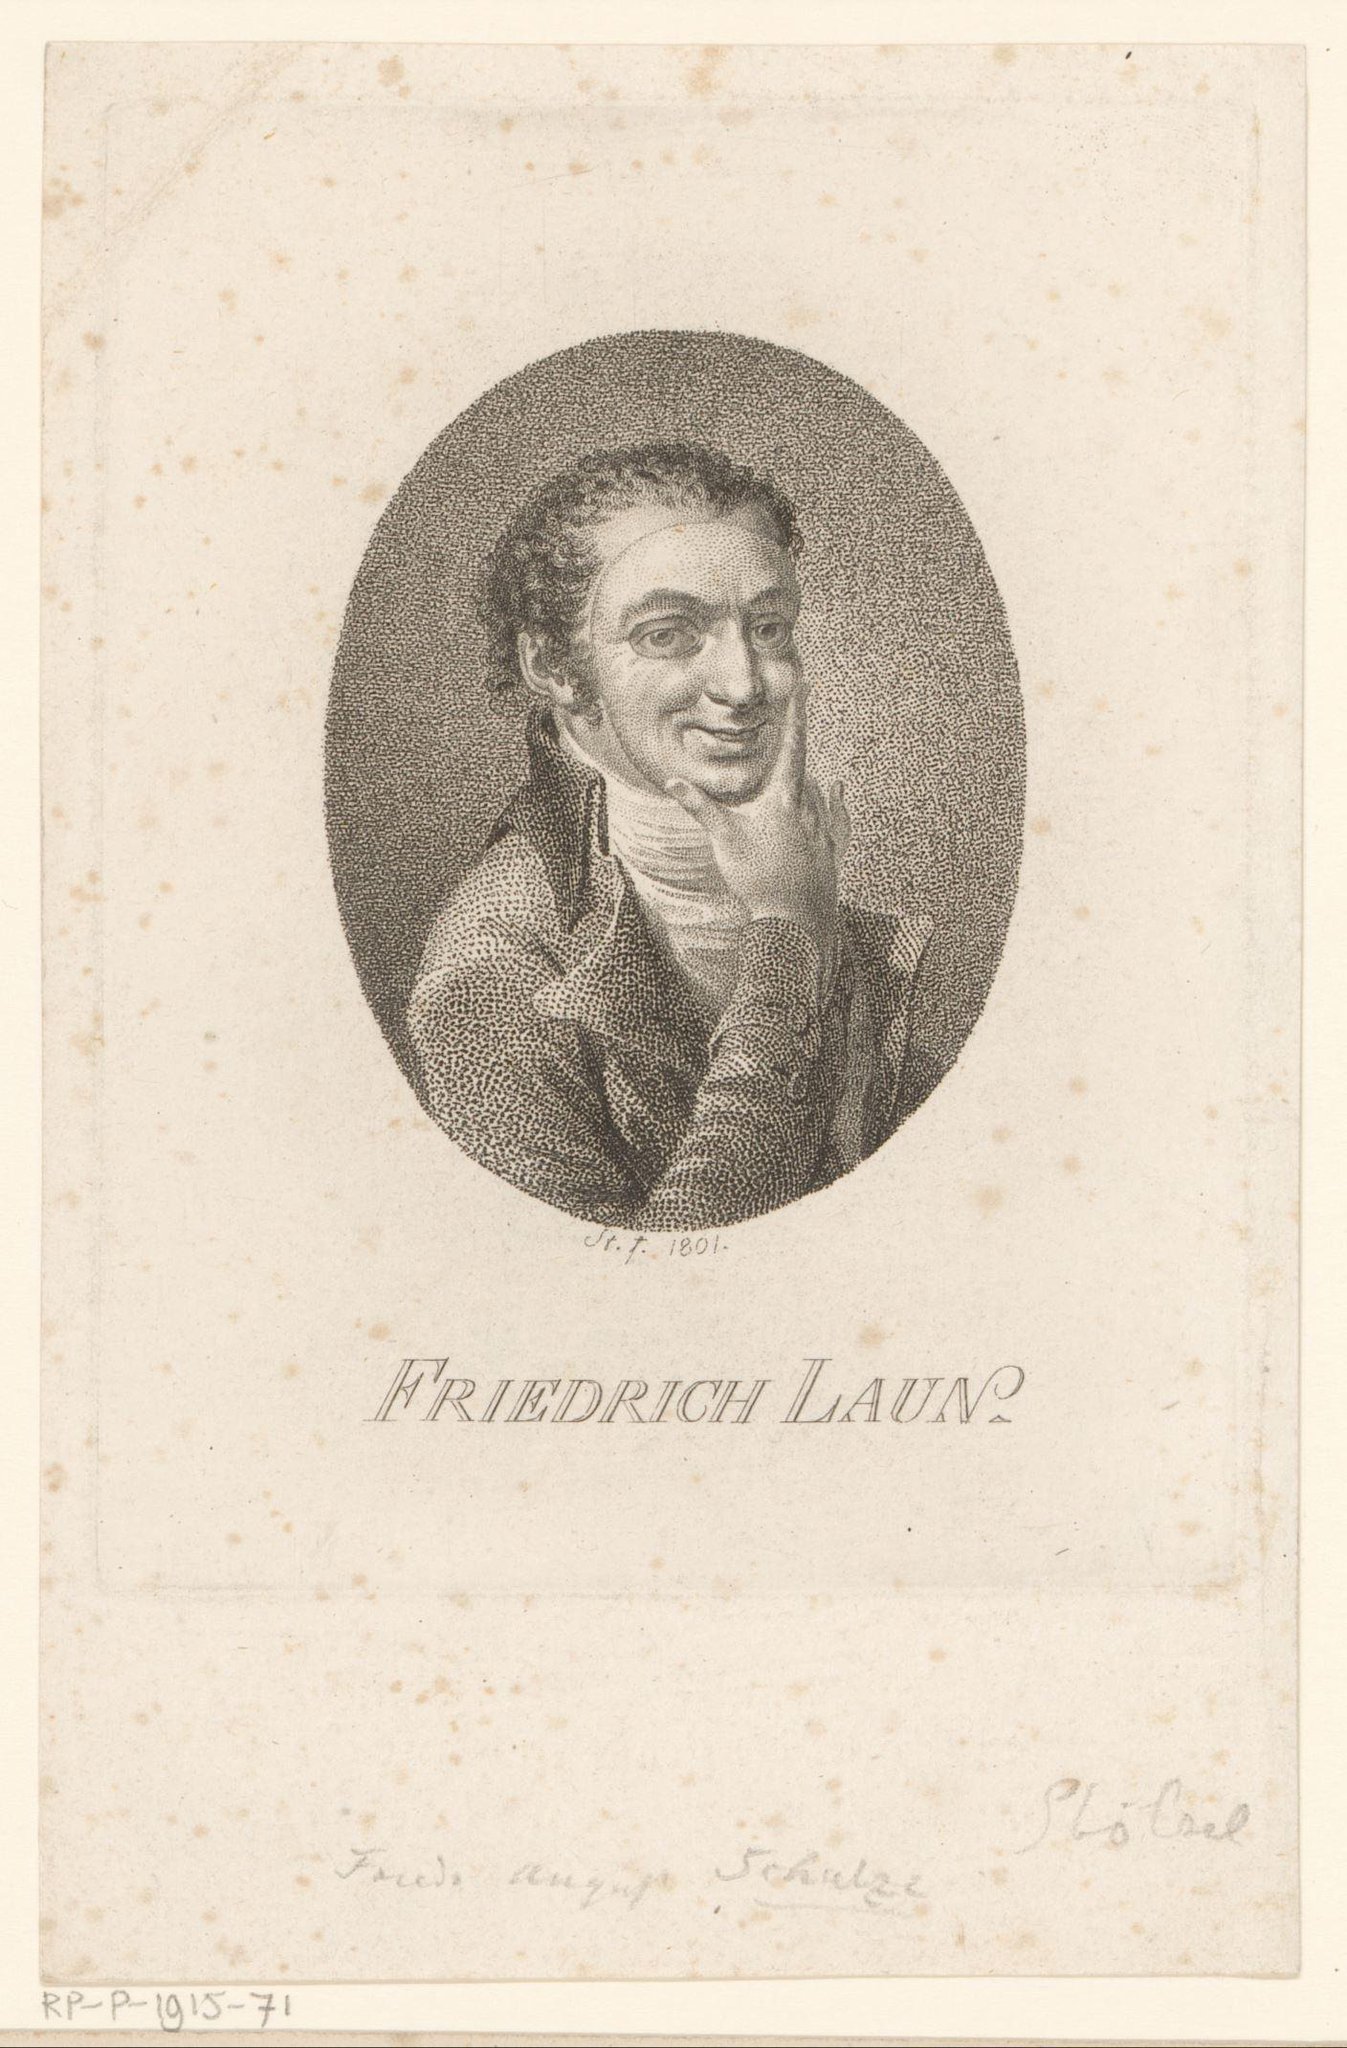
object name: print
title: Portret van Friedrich Laun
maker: christian friedrich stölzel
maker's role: draughtsman, print maker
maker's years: 1751-1816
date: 1801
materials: paper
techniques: etching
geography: dresden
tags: historical persons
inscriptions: collector's mark: Lugt 2228